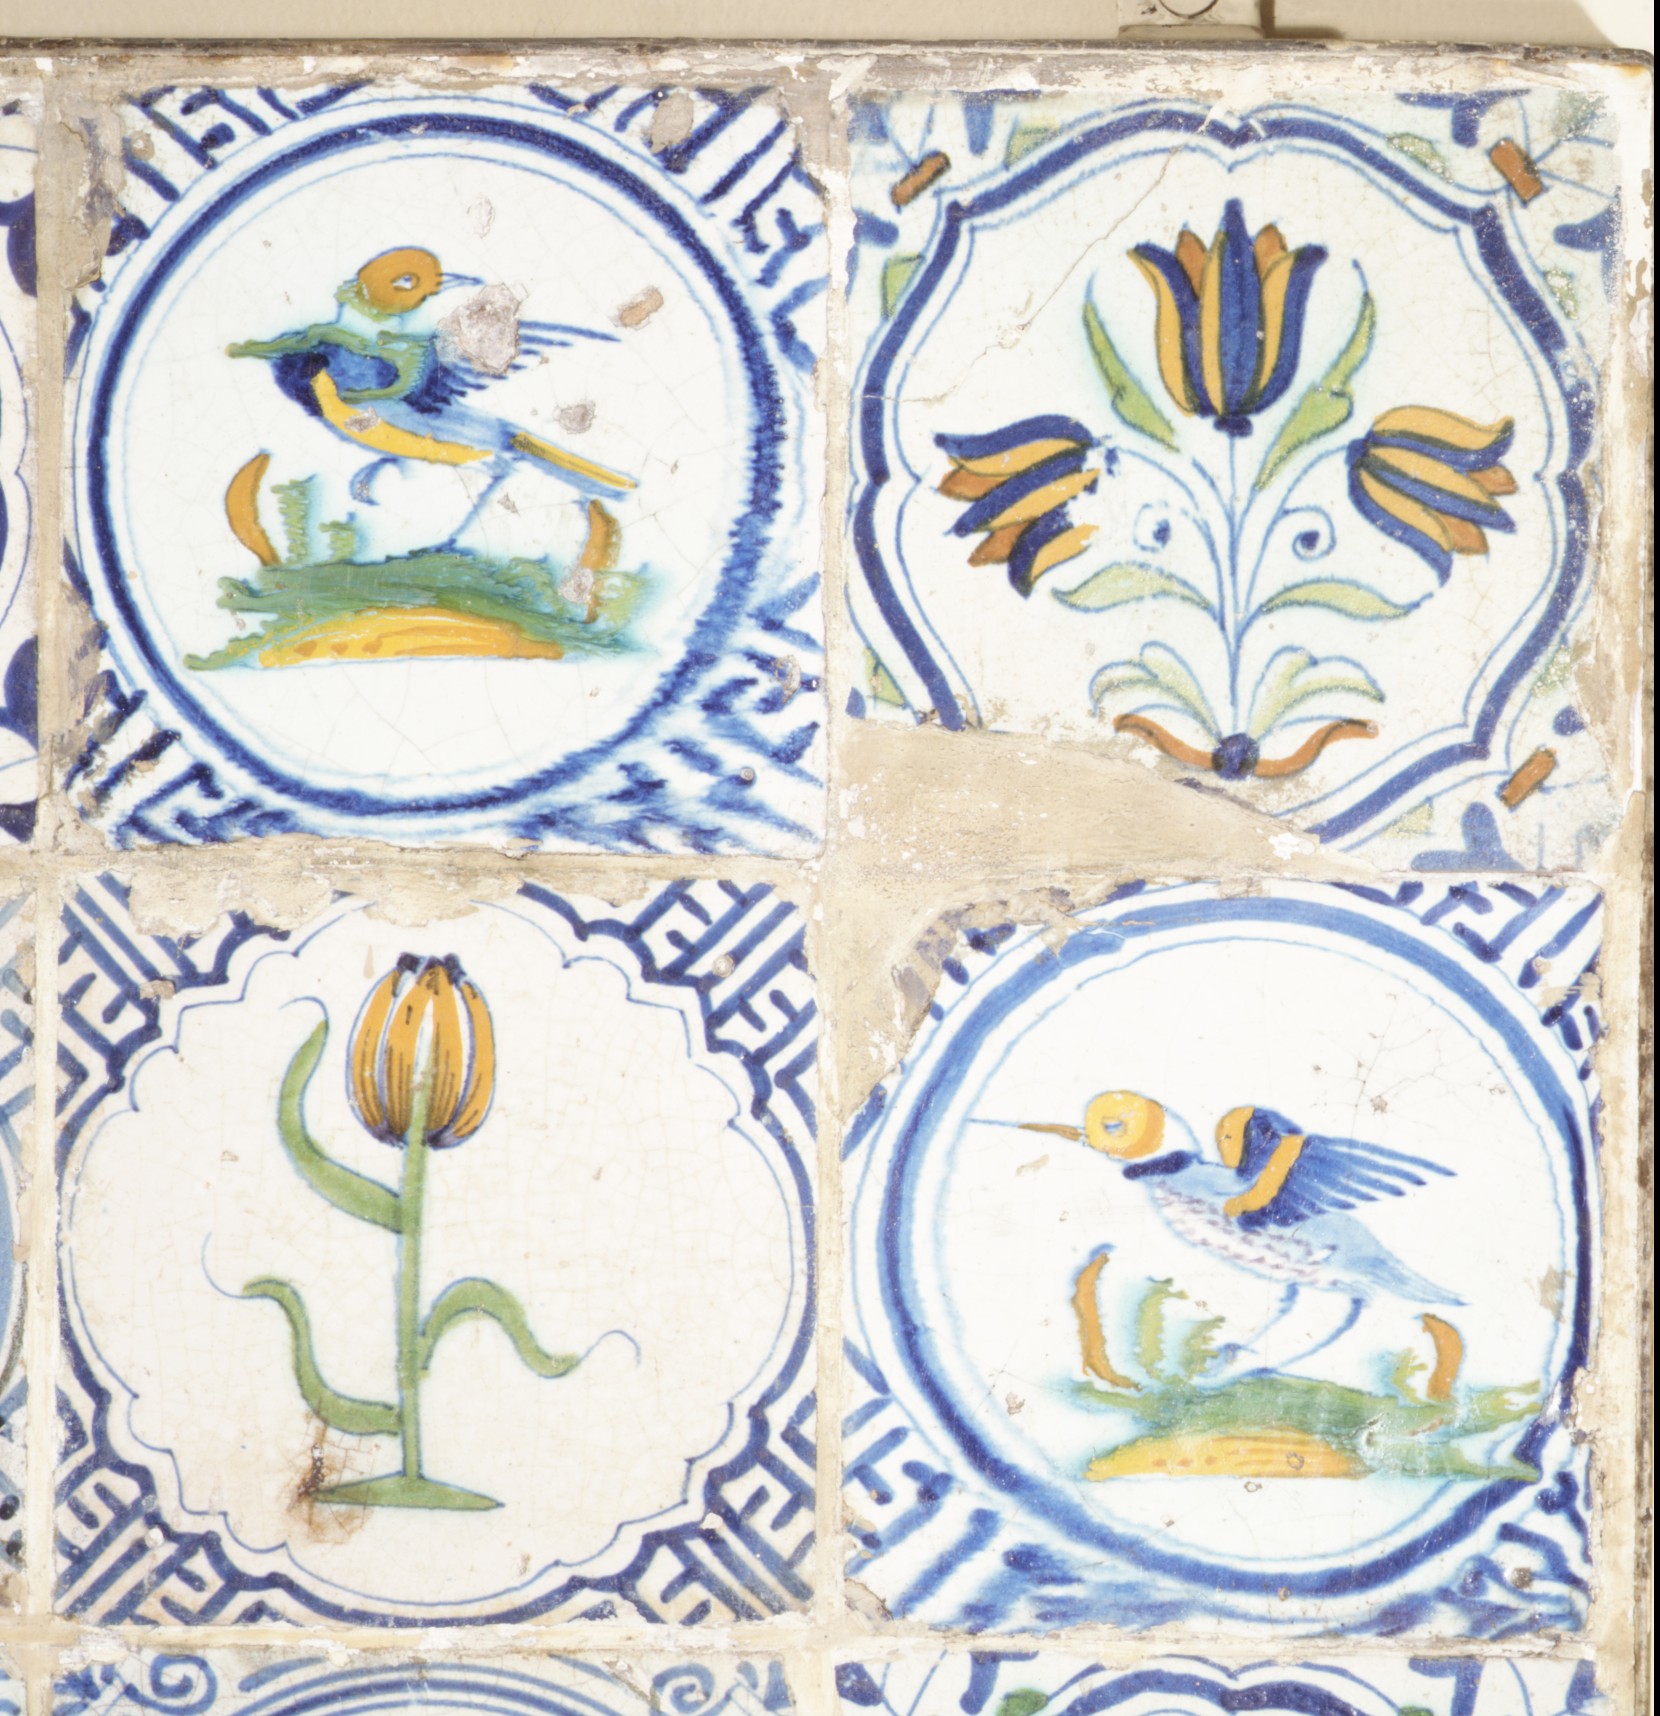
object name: tile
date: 1640-1660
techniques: glazing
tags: birds,flowers